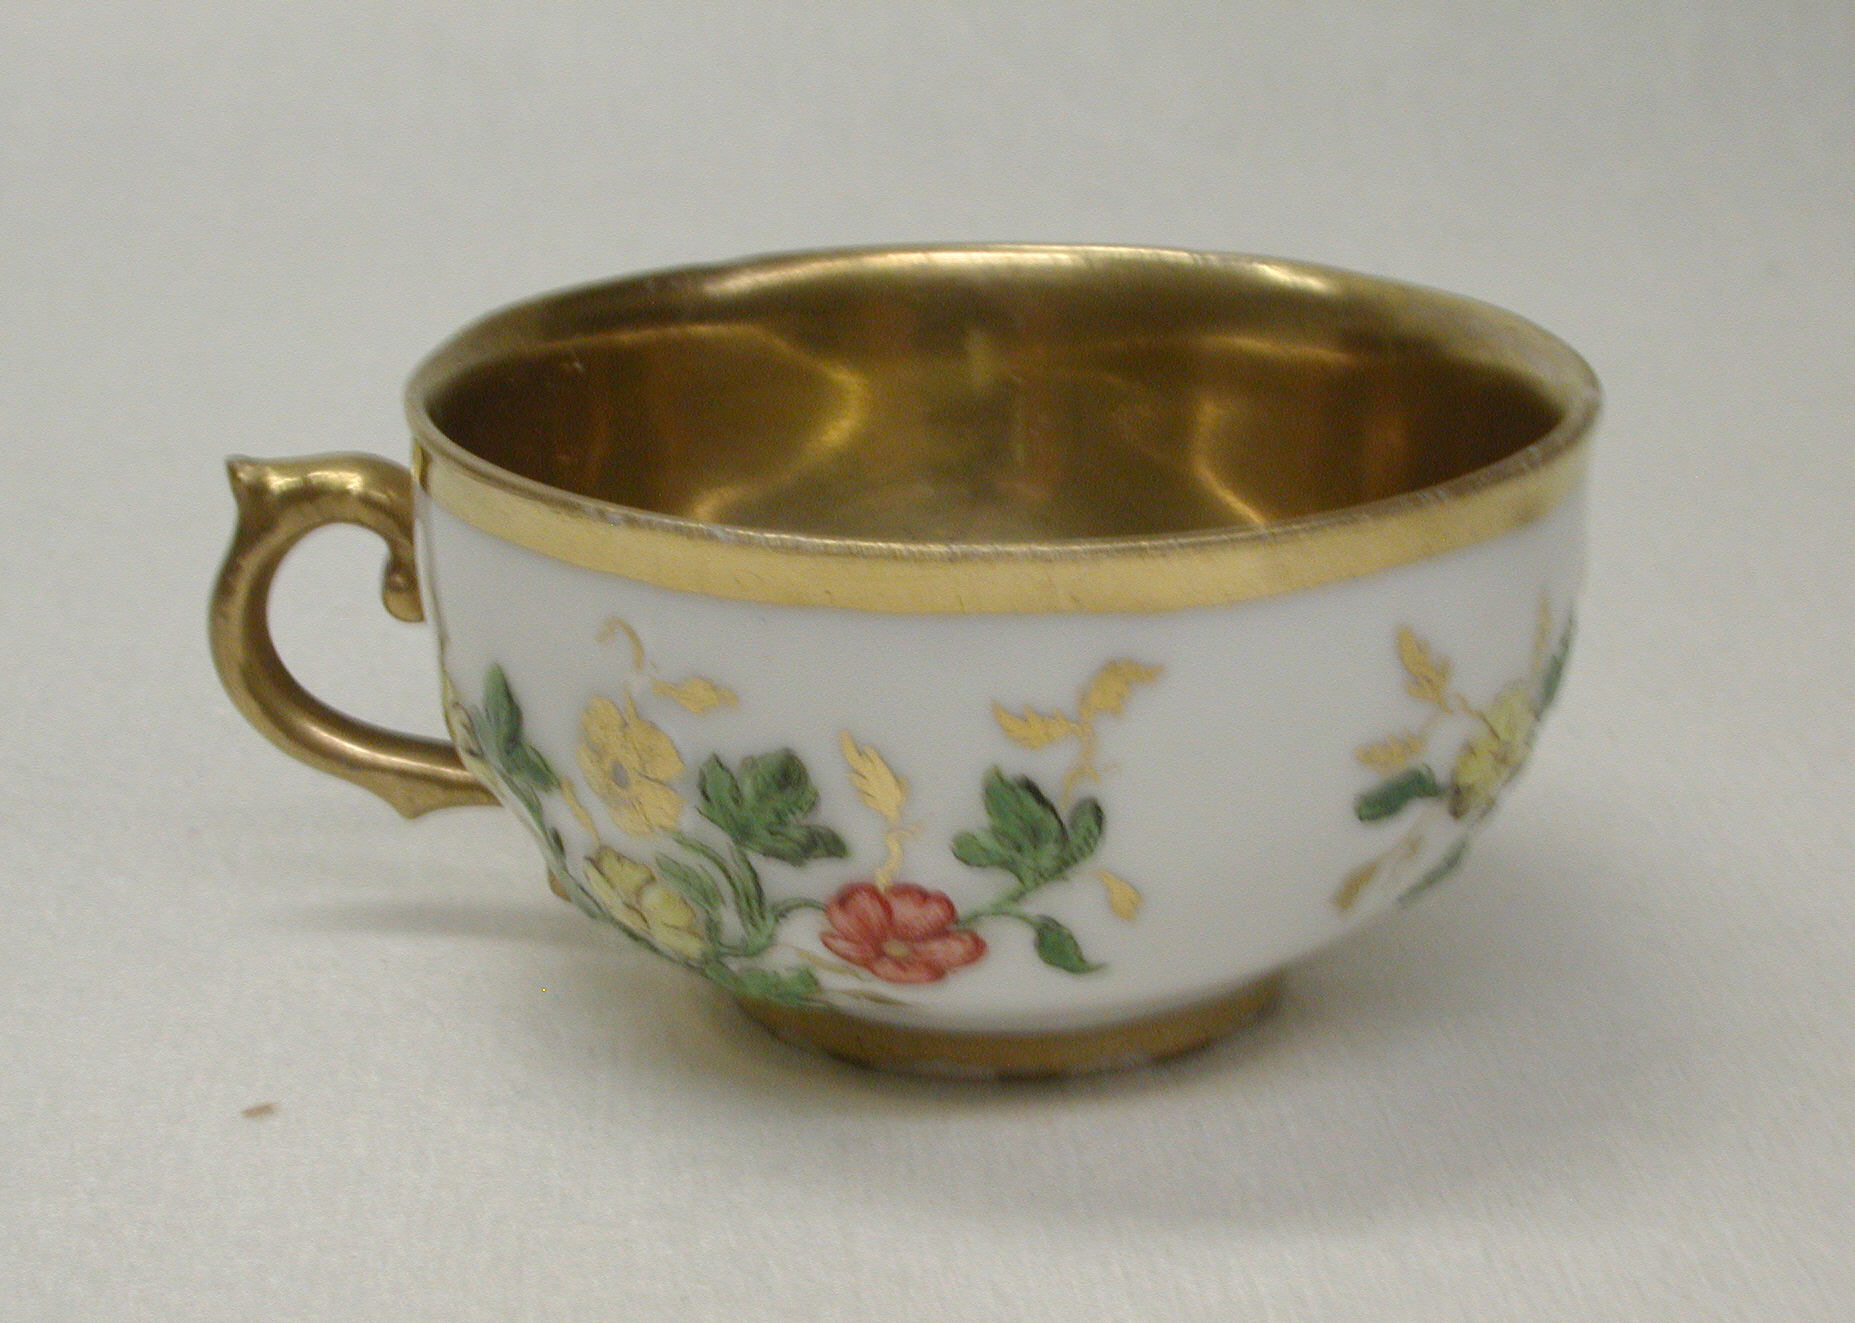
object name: teacup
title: Tea cup (part of a service)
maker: nymphenburg porcelain manufactory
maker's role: manufactory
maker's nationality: german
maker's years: 1747-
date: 1760-1765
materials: hard paste porcelain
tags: men,flowers